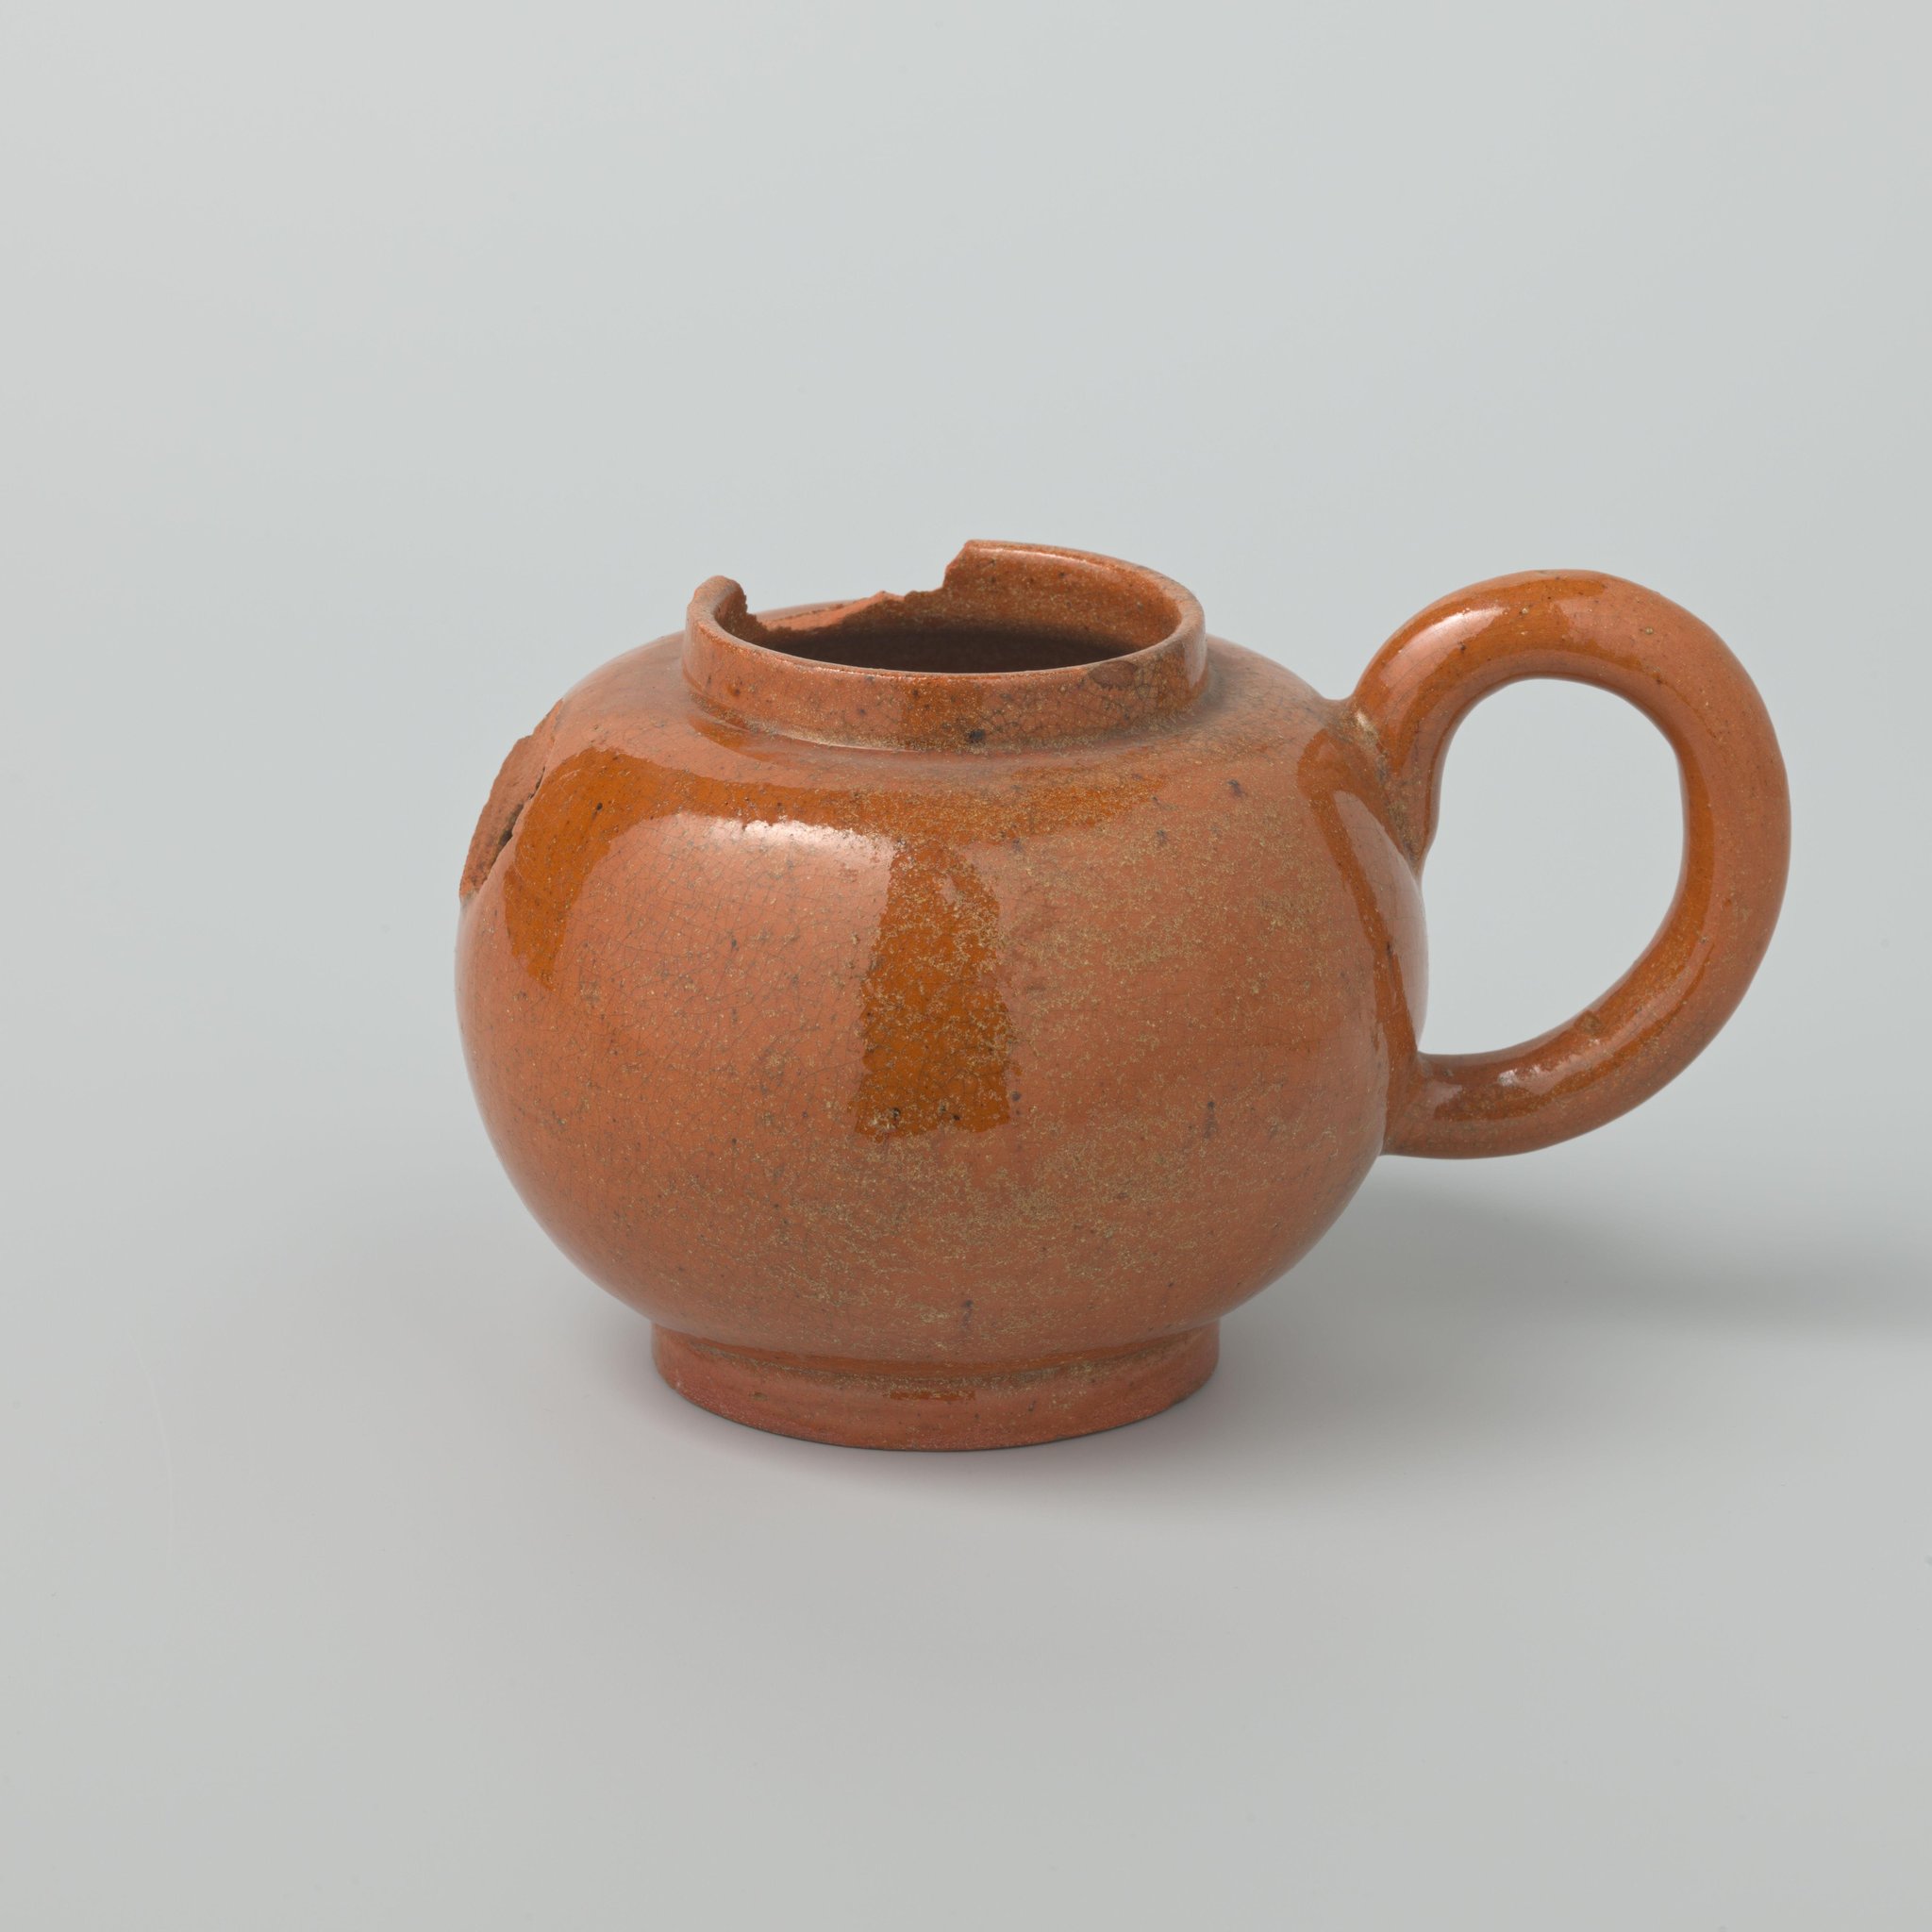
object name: teapot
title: Theepot met een geel glazuur (De Caluwe bakafval)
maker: jacobus de caluwe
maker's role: plateelbakkerij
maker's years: -1730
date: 1700-1725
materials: earthenware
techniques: firing, vitrification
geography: delft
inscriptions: mark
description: Toegeschreven aan Jacobus de Caluwe, omdat dit voorwerp samen met gemerkte stukken (‘Jacobus De Caluwe’ en rennend hert) gevonden is op de plaats waar zich De Caluwes tweede werkplaats bevond. Er is een duidelijke stilistische overeenkomst tussen de gemerkte en niet gemerkte voorwerpen uit deze archeologische vondst.